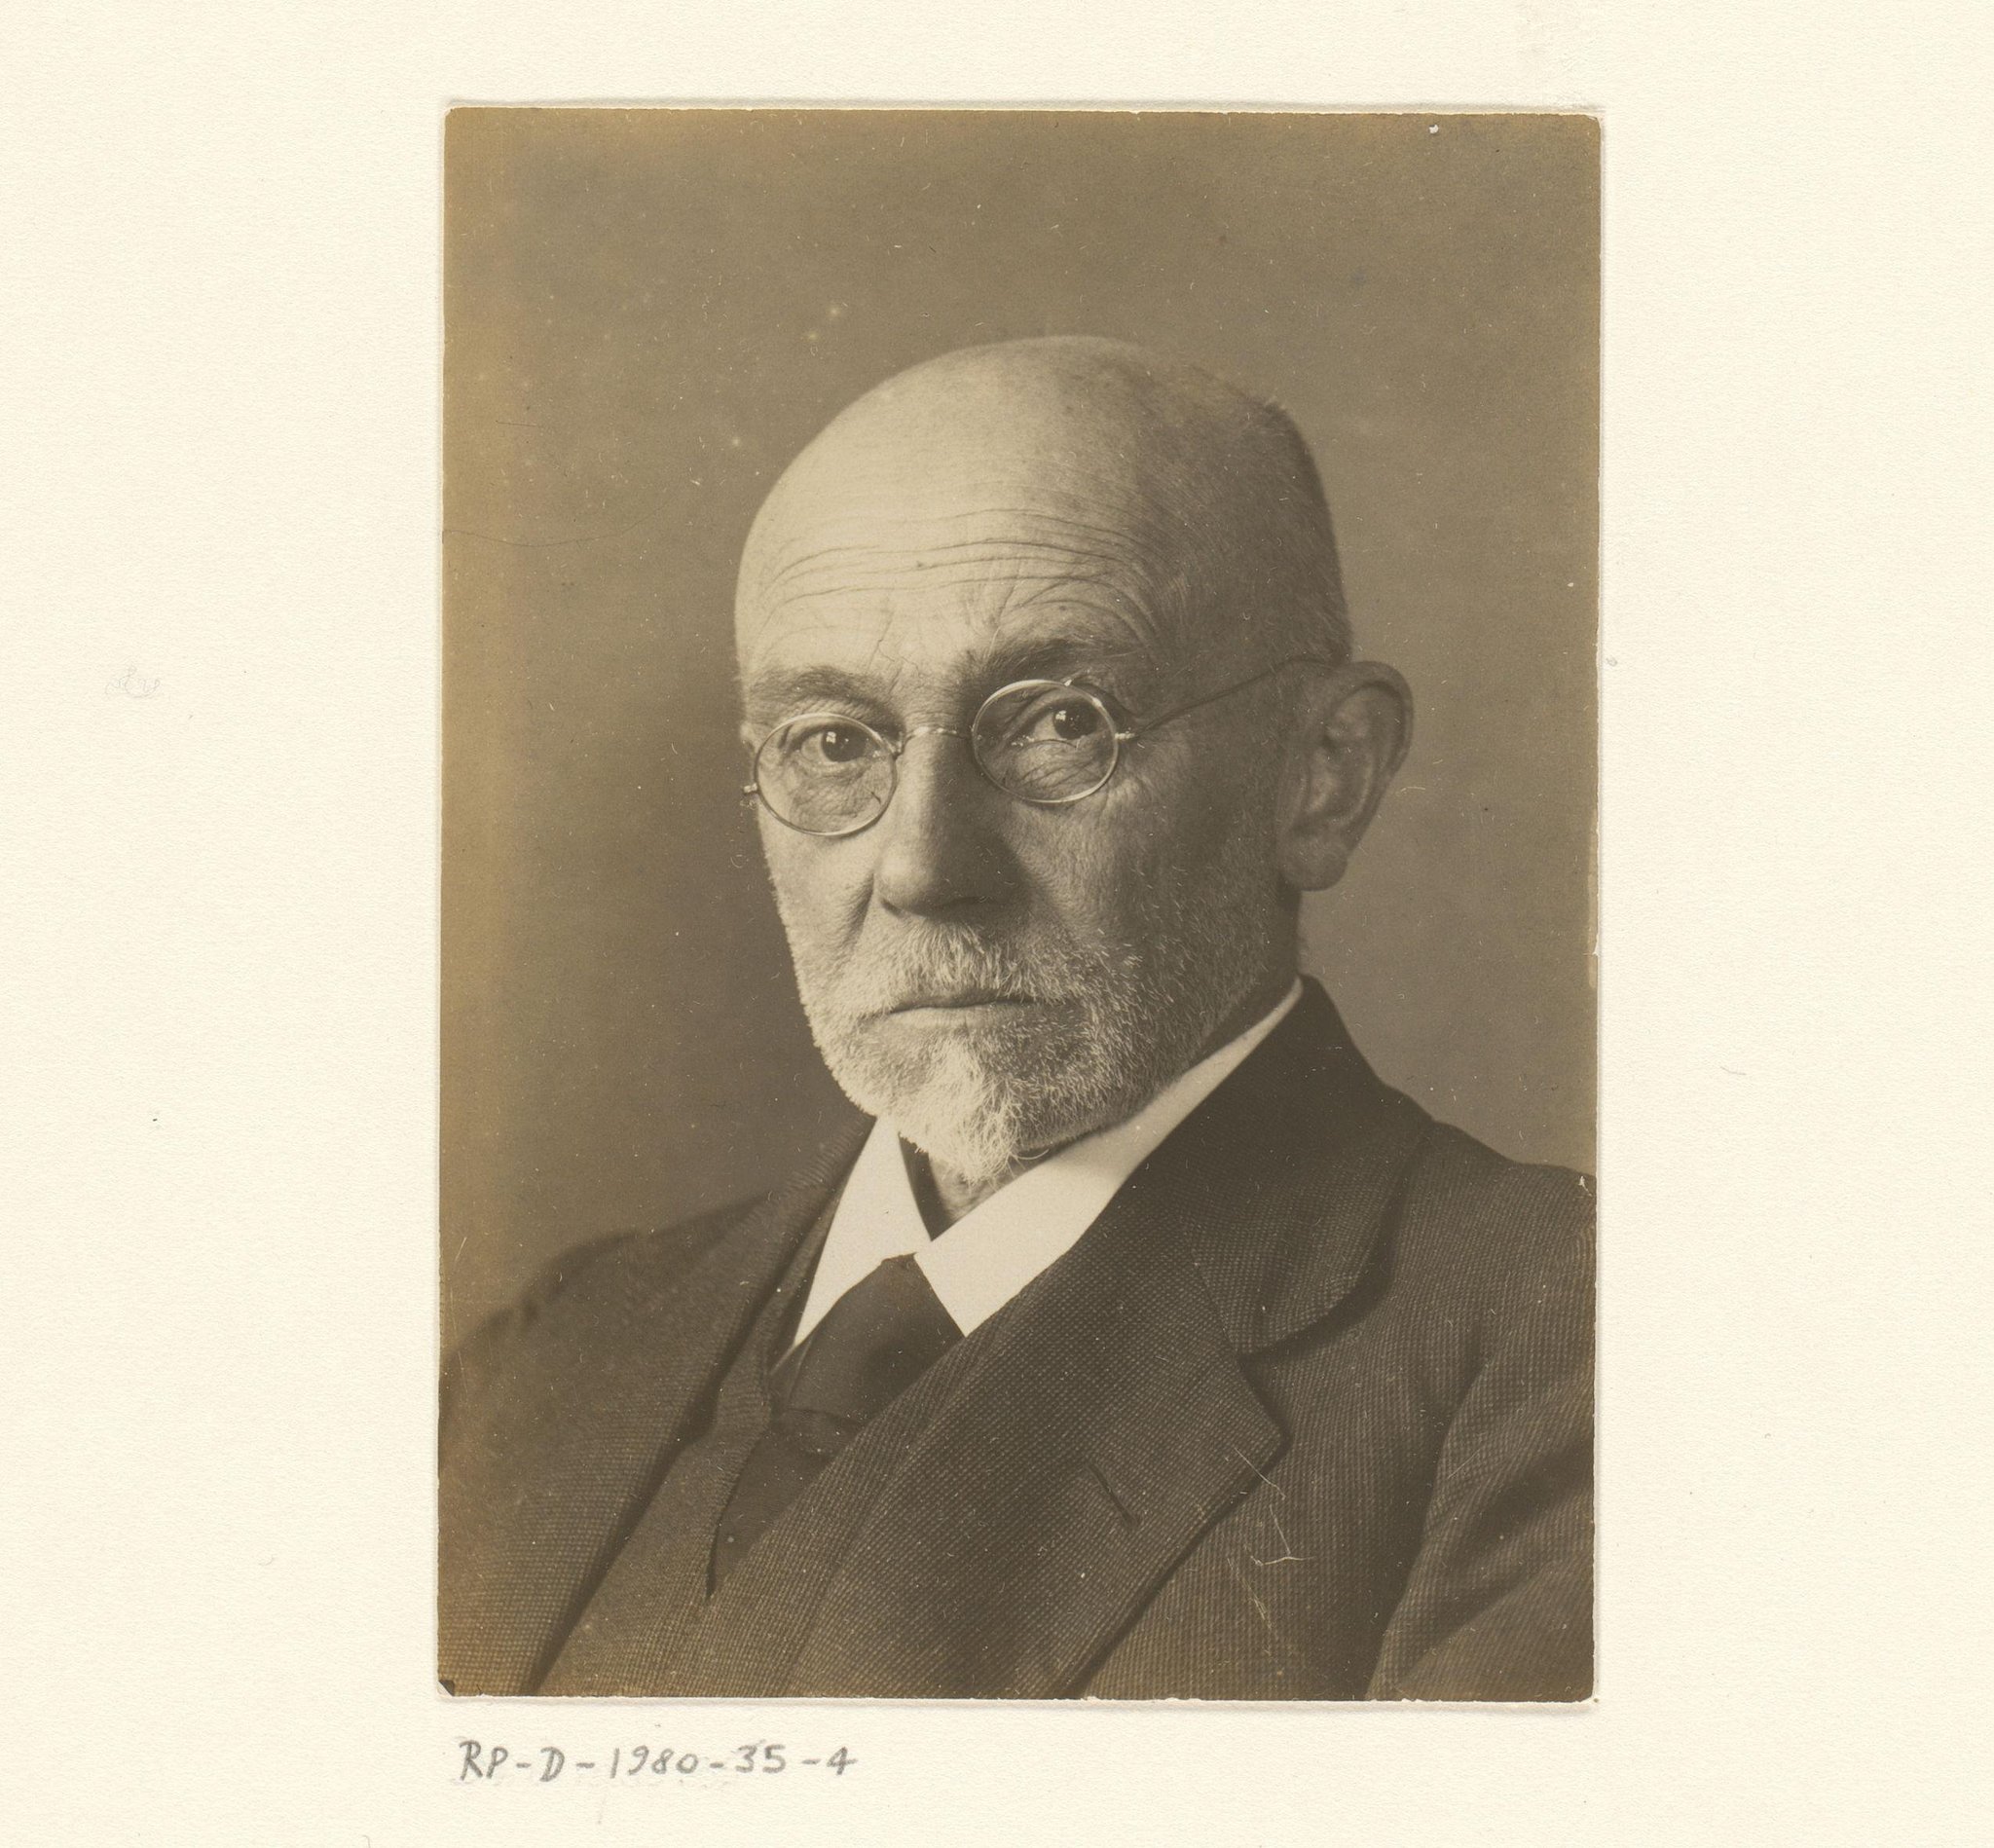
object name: photograph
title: Portret van Maurits van der Valk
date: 1910-1930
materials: paper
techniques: gelatin silver print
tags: amsterdam, print maker, draughtsman, maurits van der valk, historical persons, portrait, self-portrait of graphic artist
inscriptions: inscription: ‘M v/d Valk’, collector's mark: Lugt 2228a